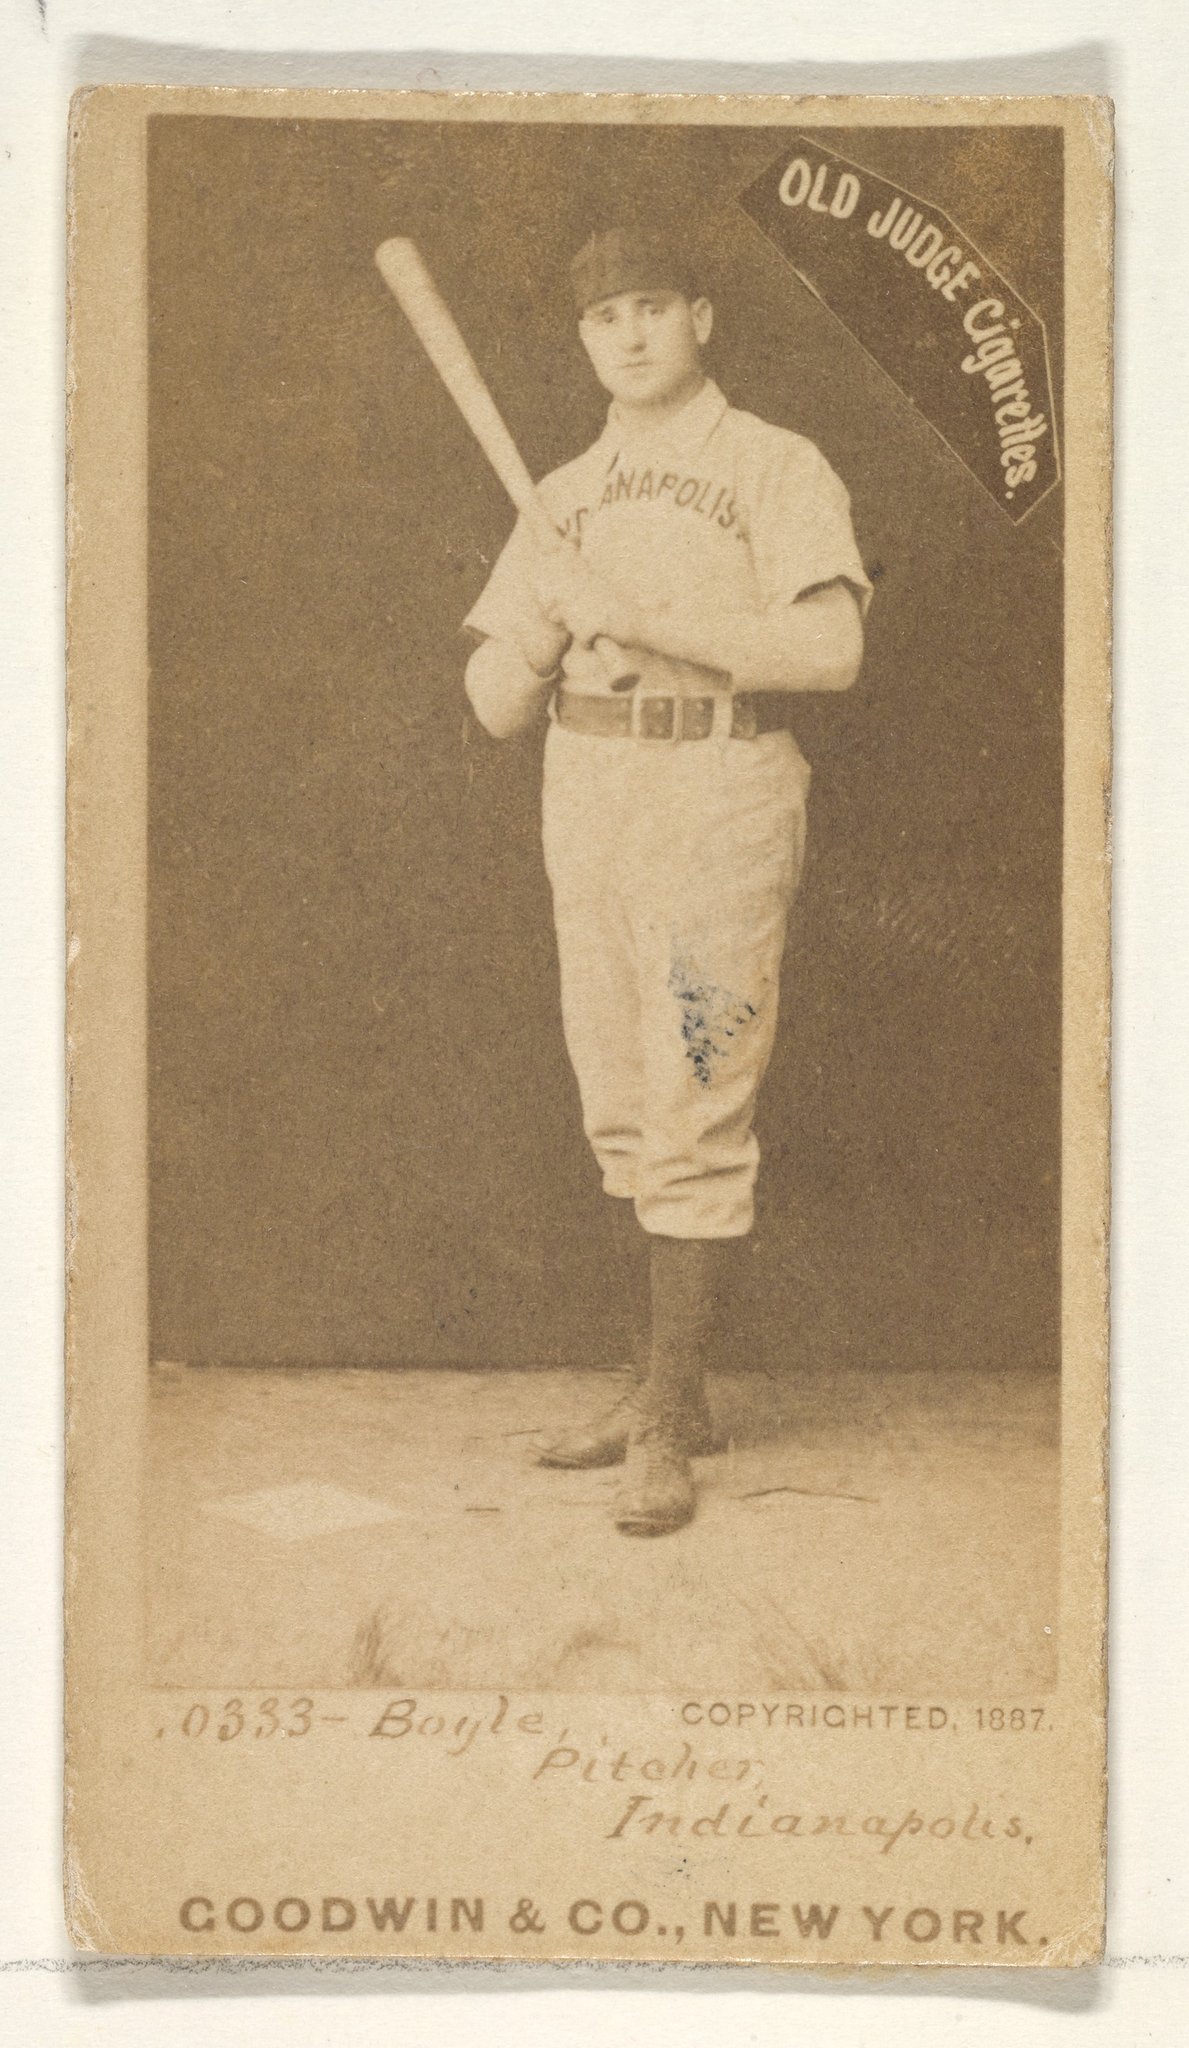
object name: baseball card, photograph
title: Boyle, Pitcher, Indianapolis, from the Old Judge series (N172) for Old Judge Cigarettes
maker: goodwin & company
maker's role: publisher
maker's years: 1850-1950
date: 1887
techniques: albumen silver print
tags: men,portraits,baseball,athletes